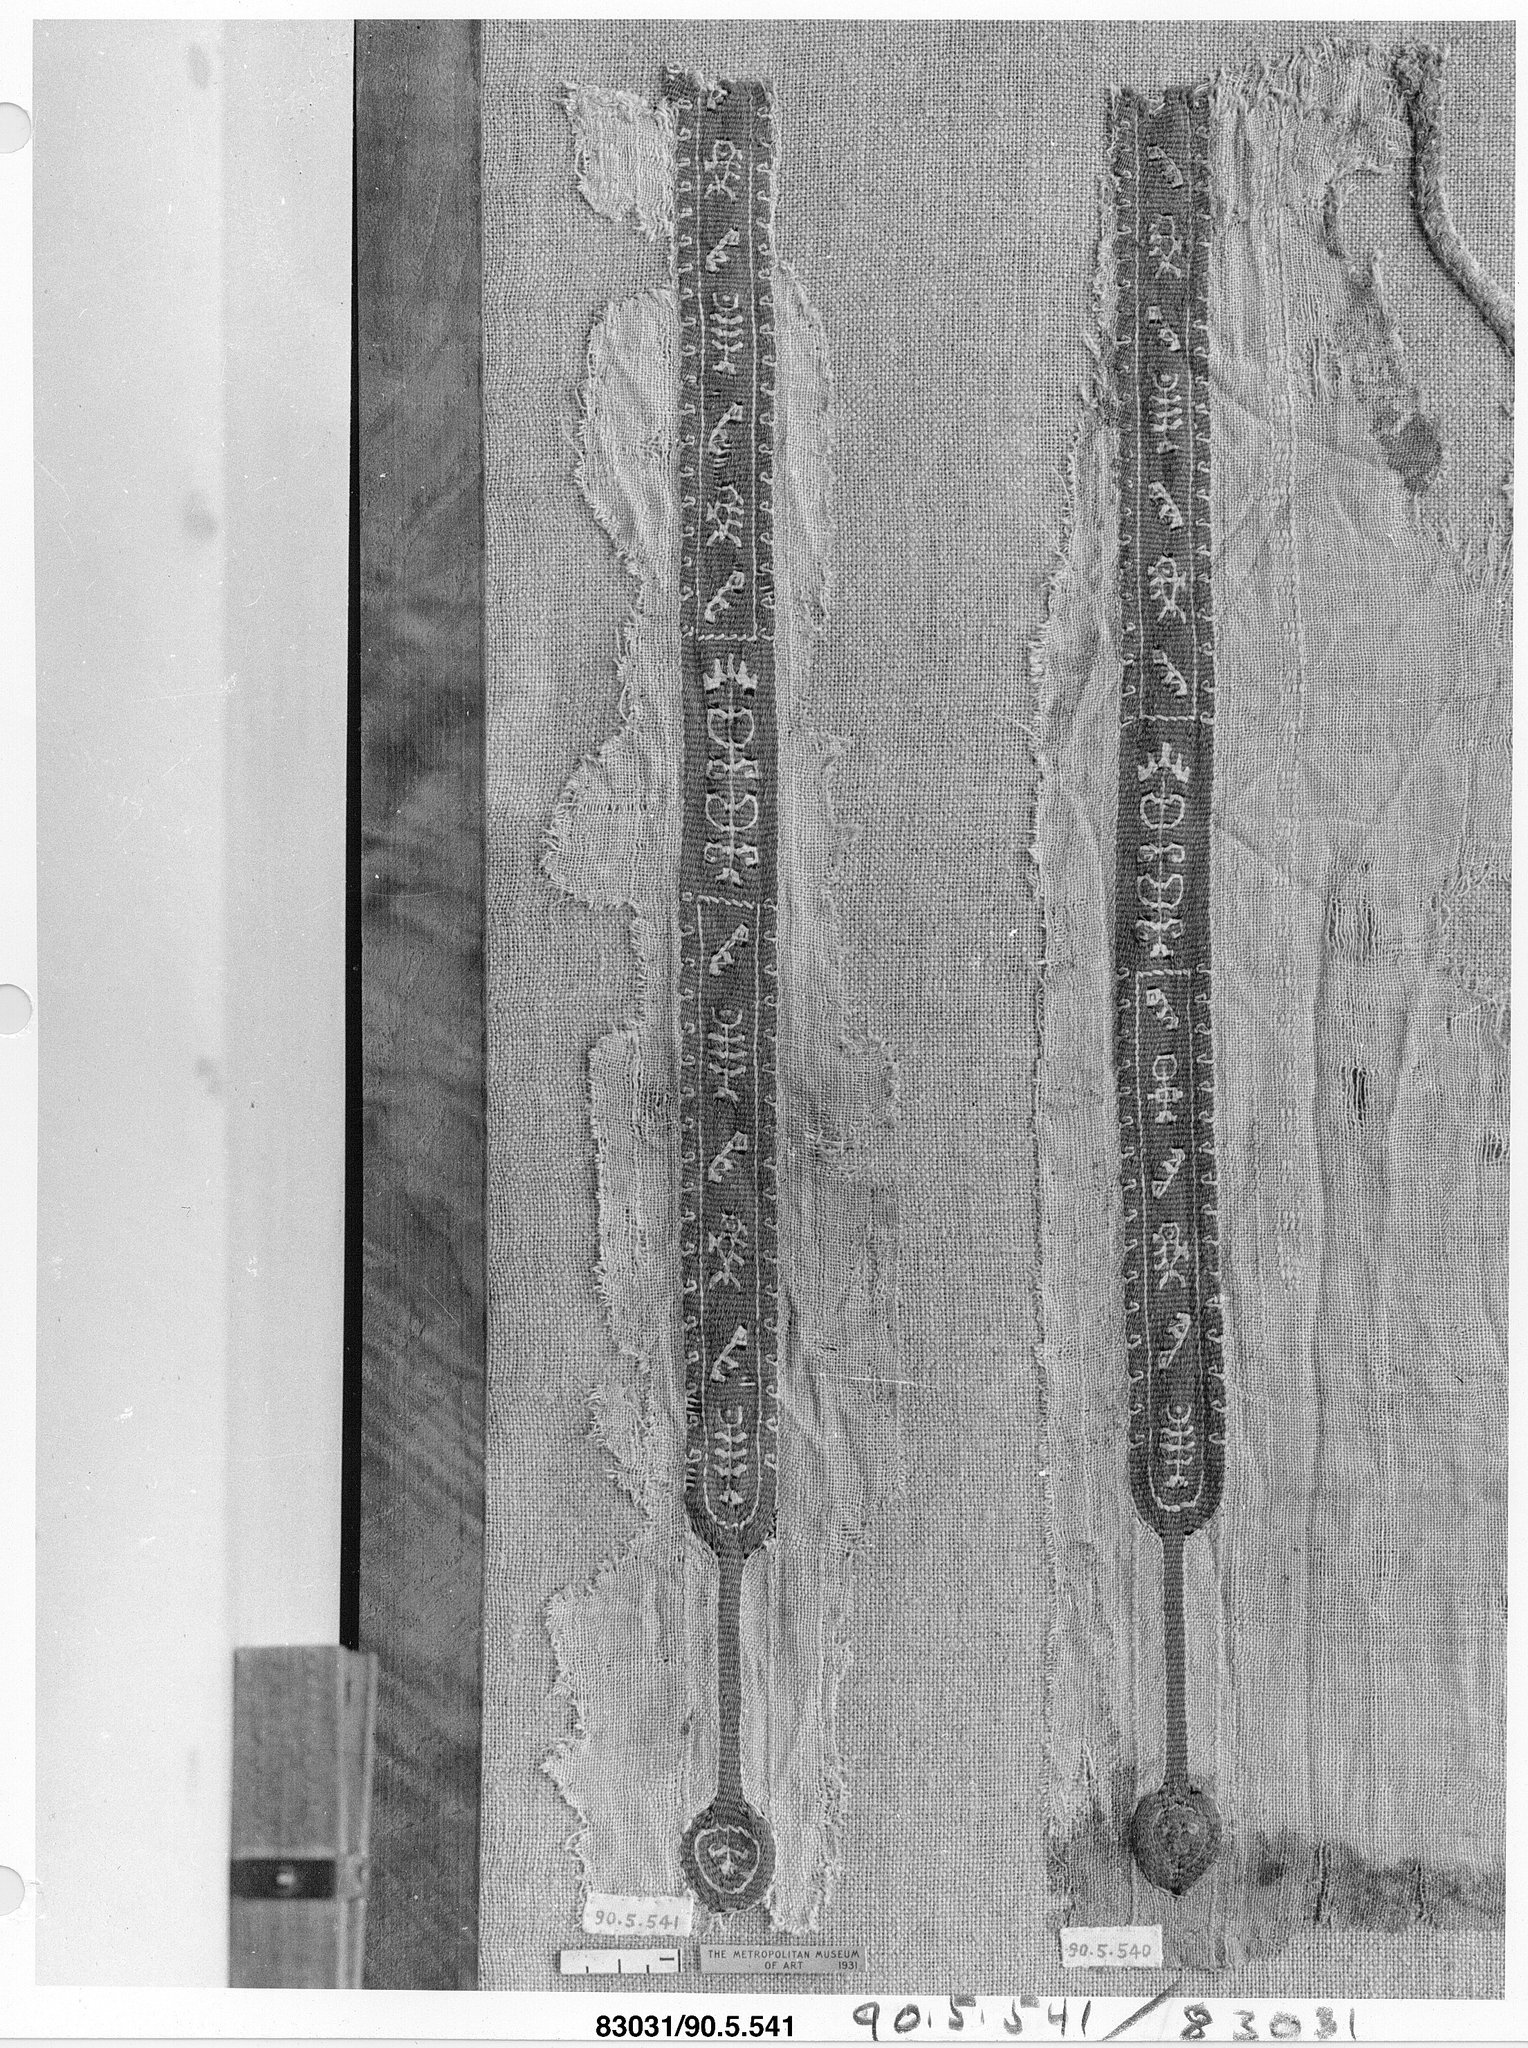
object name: tunic fragment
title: Fragment of a Tunic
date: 301-500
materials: linen, wool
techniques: weave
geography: egypt